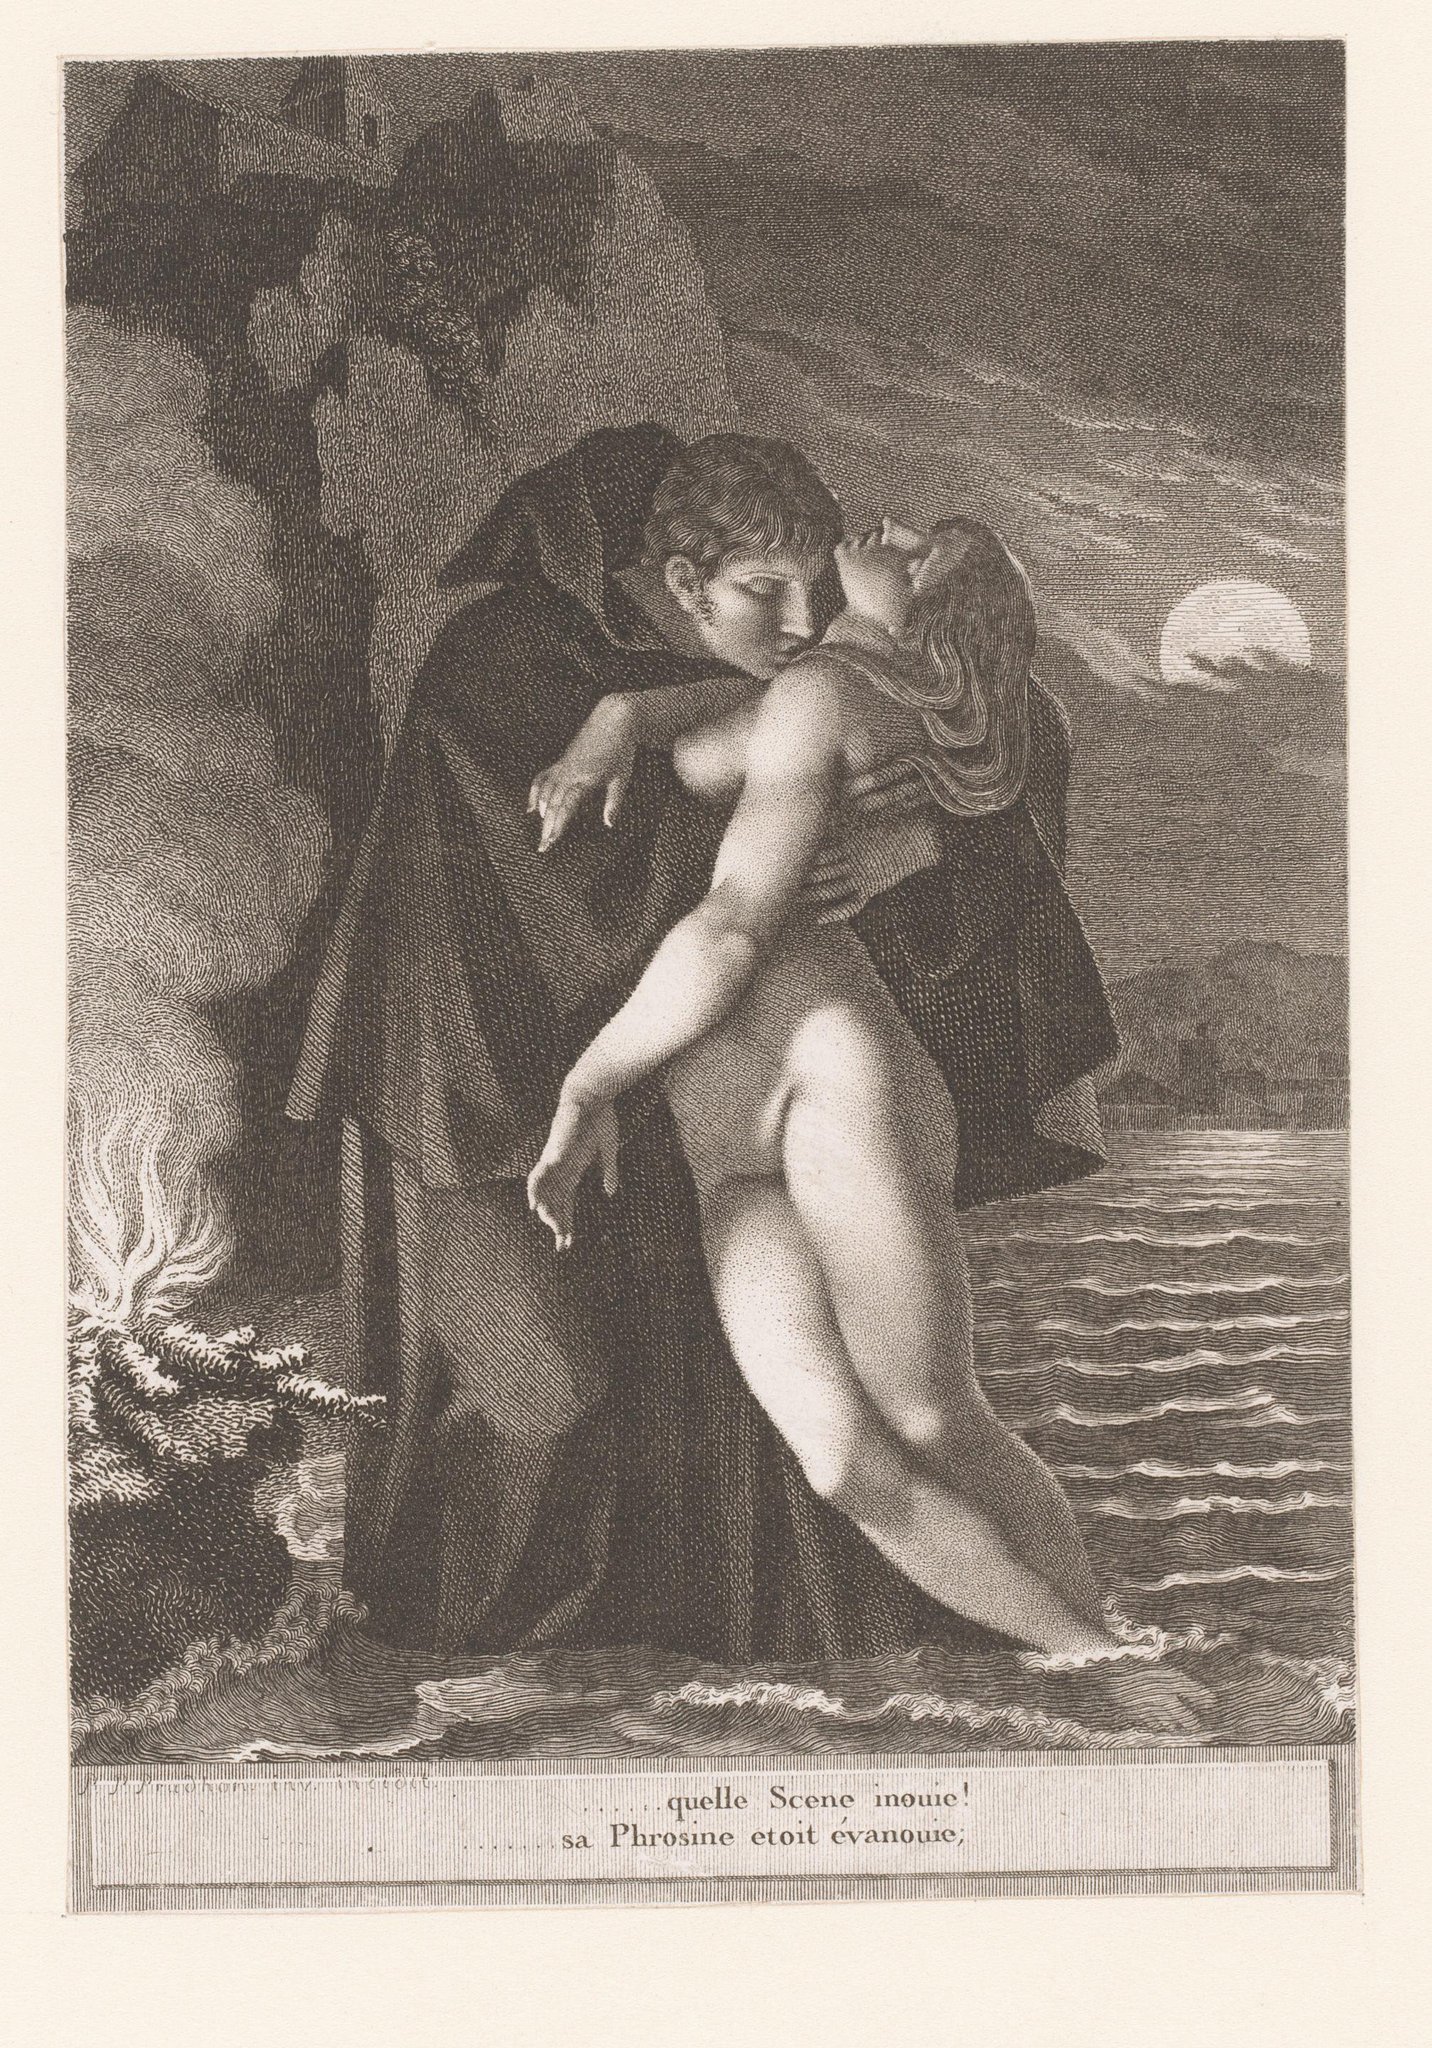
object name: print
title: Phrosine et Mélidore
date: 1797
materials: paper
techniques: engraving, etching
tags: saving a person from drowning, couple of lovers, sea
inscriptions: collector's mark: Lugt 2228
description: Scène uit het gedicht van Pierre-Joseph Bernard. Mélidore redt zijn geliefde Phrosine uit de zee.